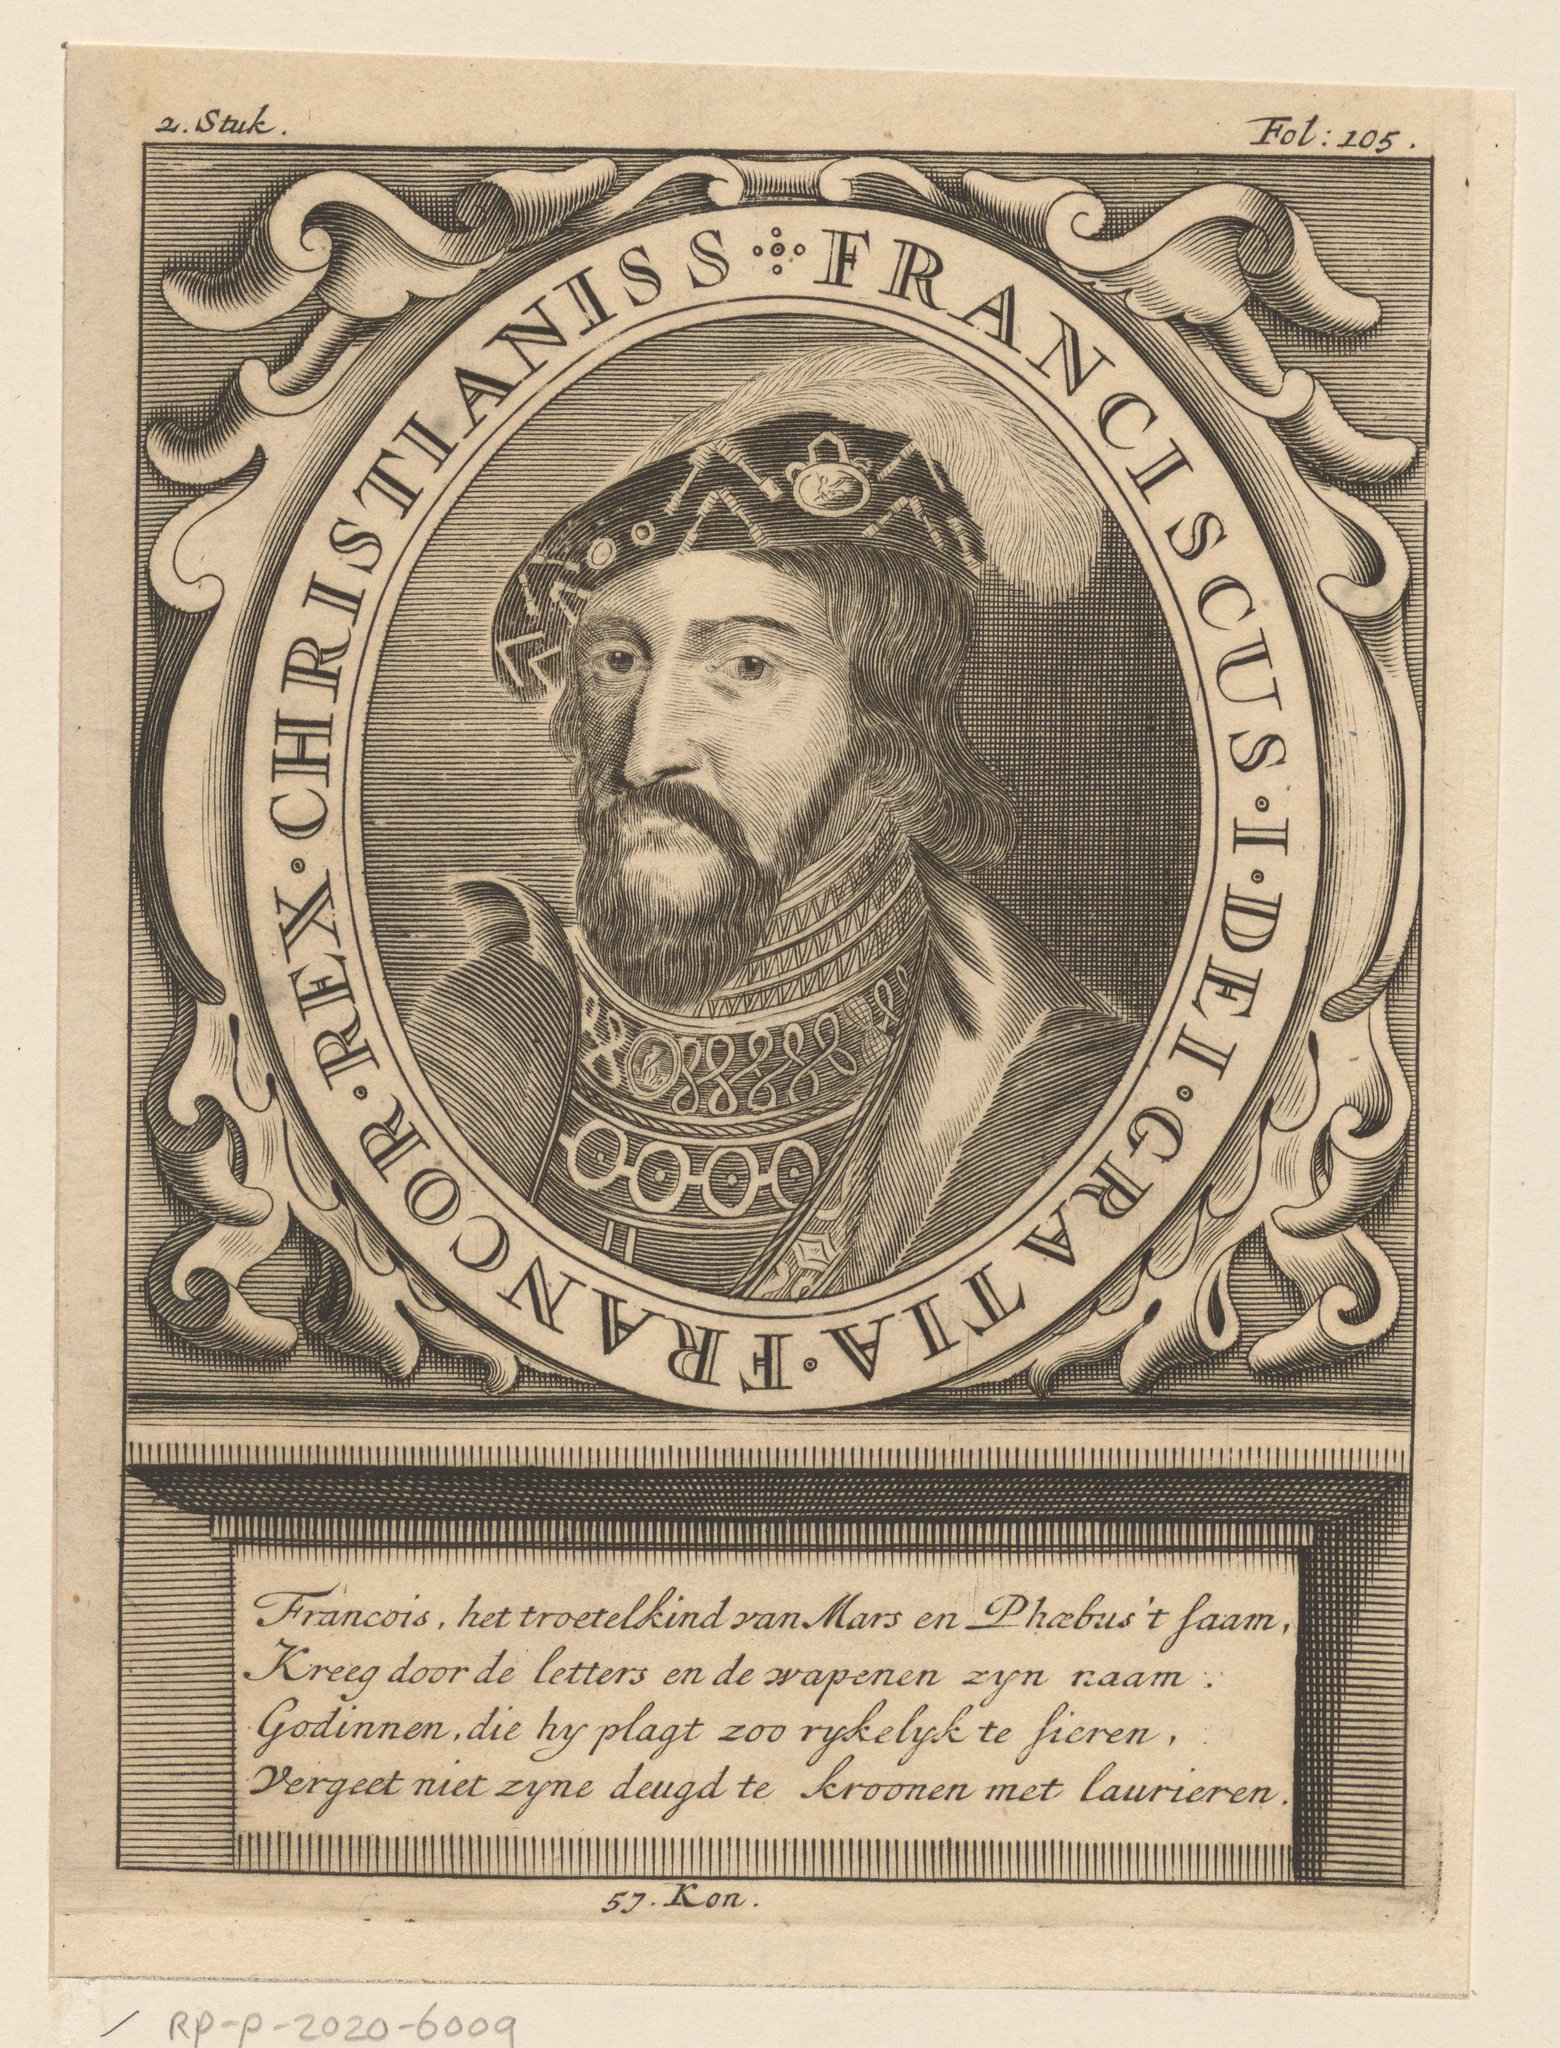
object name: print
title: Portret van Frans I van Frankrijk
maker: Anonymous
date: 1685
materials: paper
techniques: engraving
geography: northern netherlands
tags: frans i van valois-angoulême (koning van frankrijk), rocaille ornament, historical persons, king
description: Linksboven: 2. Stuk. Rechtsboven: Fol: 105. Met vierregelig lofdicht in het Nederlands onder het portret.